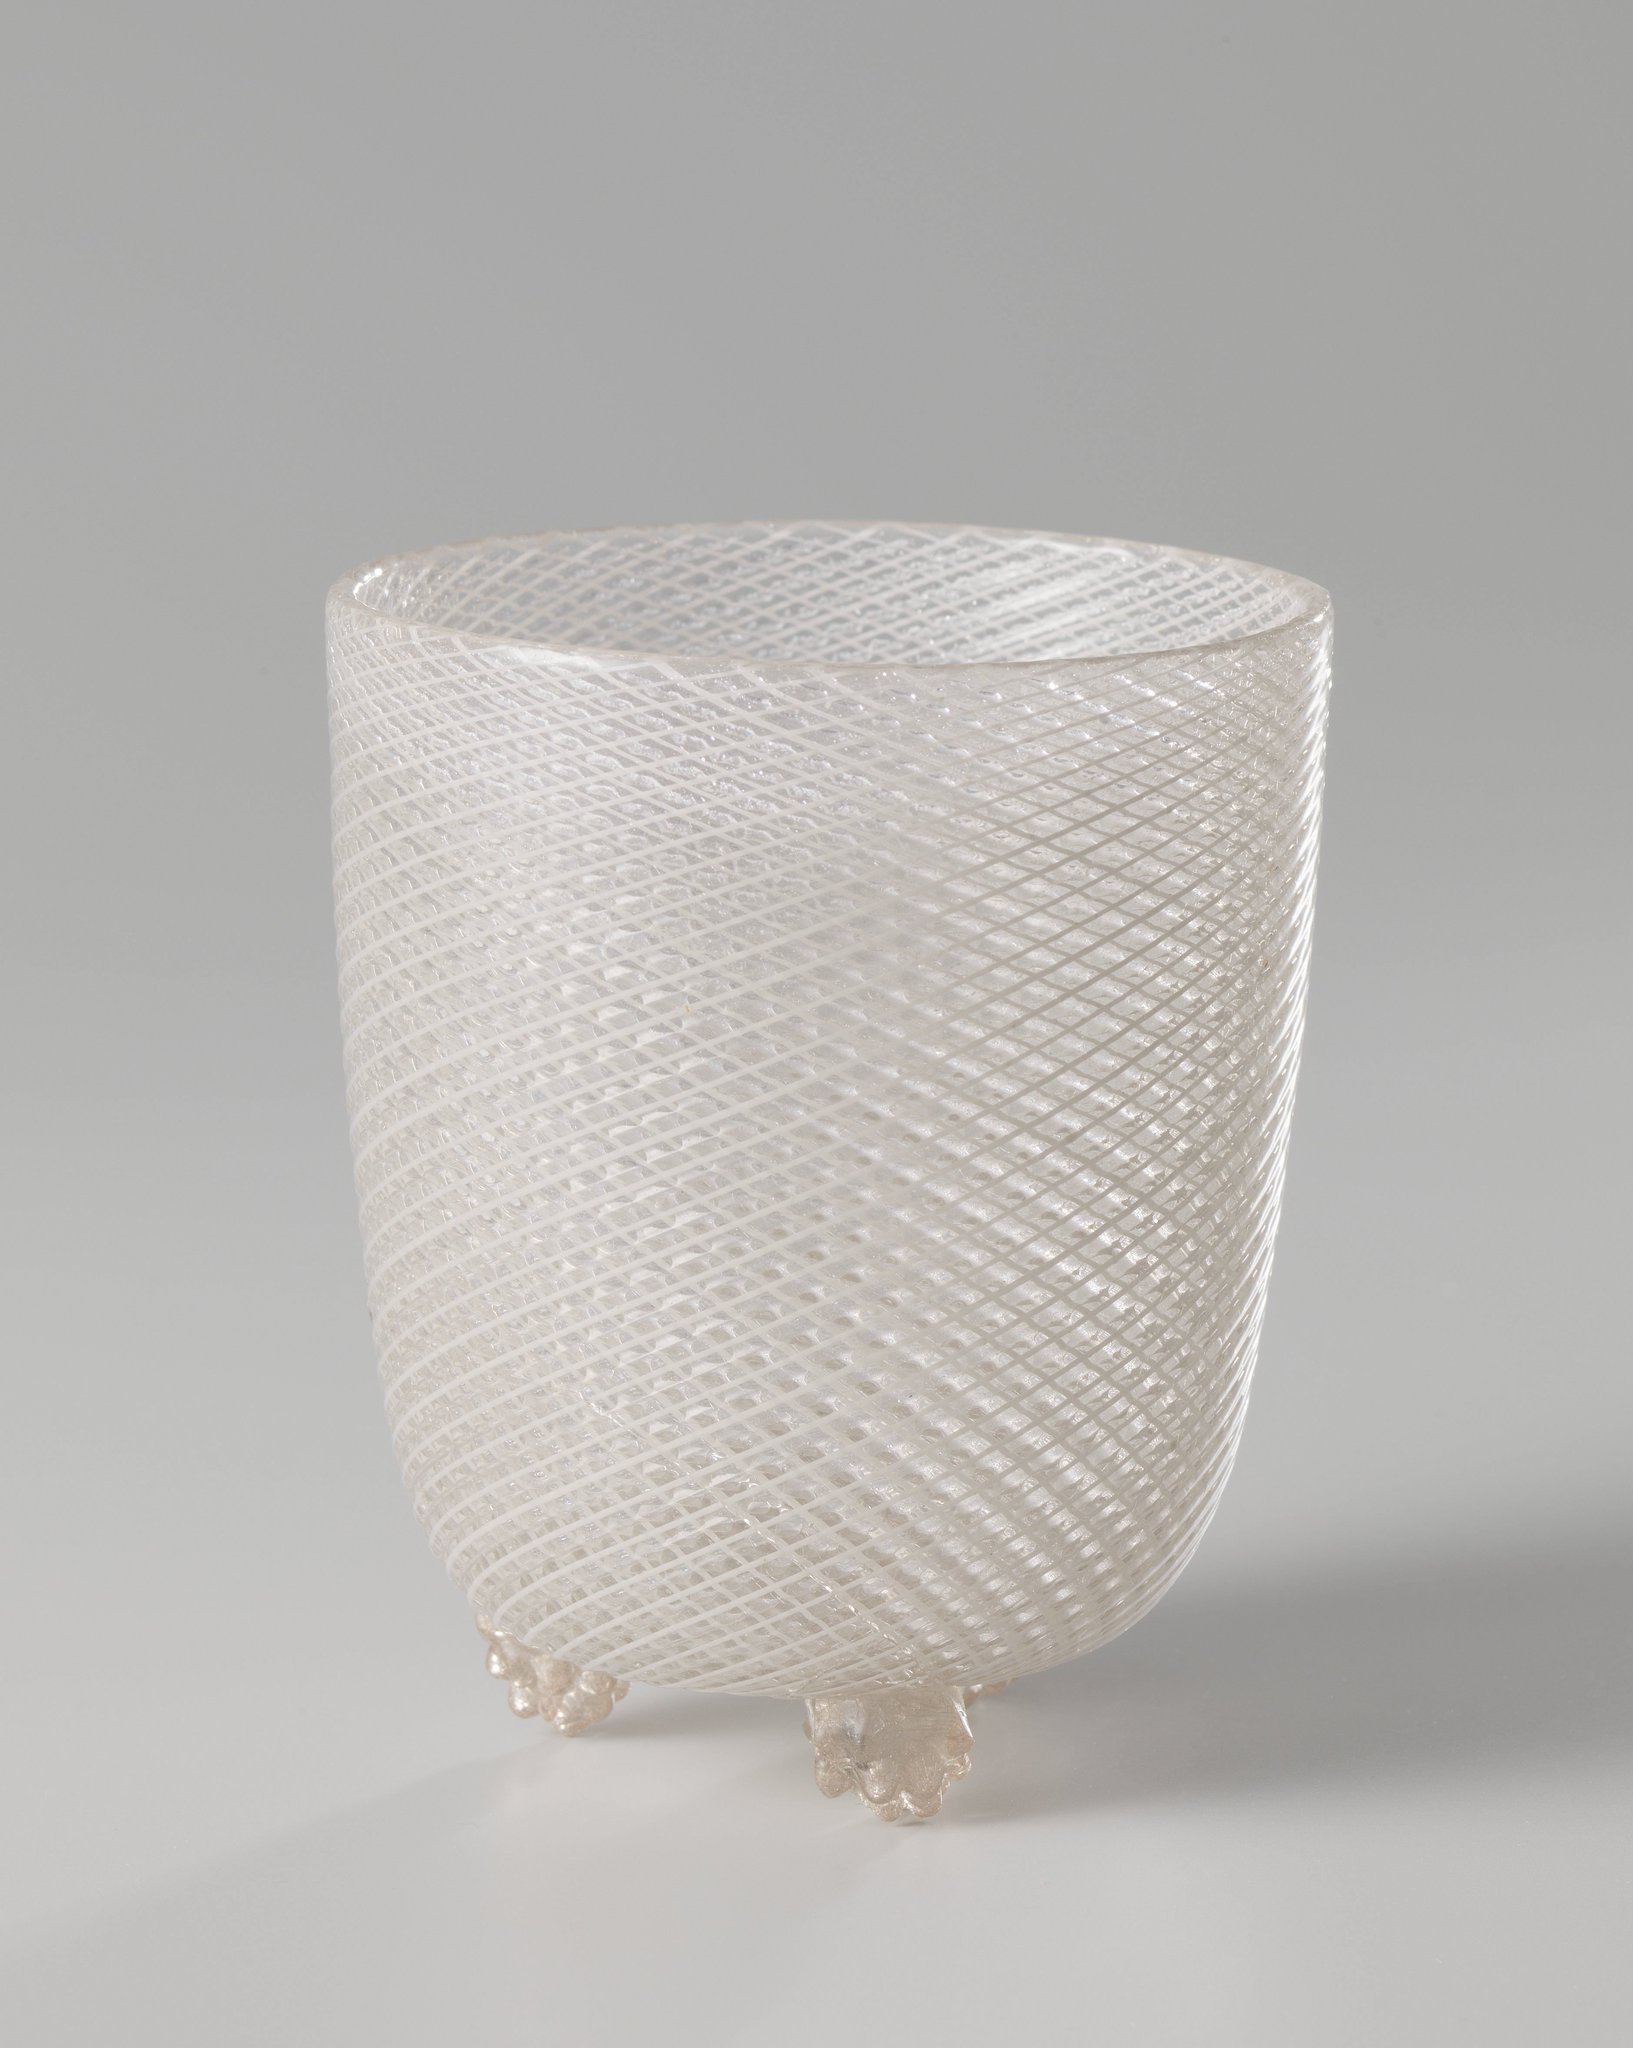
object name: cup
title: Beker op pootjes van filigraanglas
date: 1550-1700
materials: glass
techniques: façon de venise, glassblowing, vetro a reticello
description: Beker van filigraanglas 'a reticello'. Aan de onderzijde afgerond en naar boven enigszins uitlopend lichaam. Op drie kleurloze pootjes in de vorm van braamnoppen.